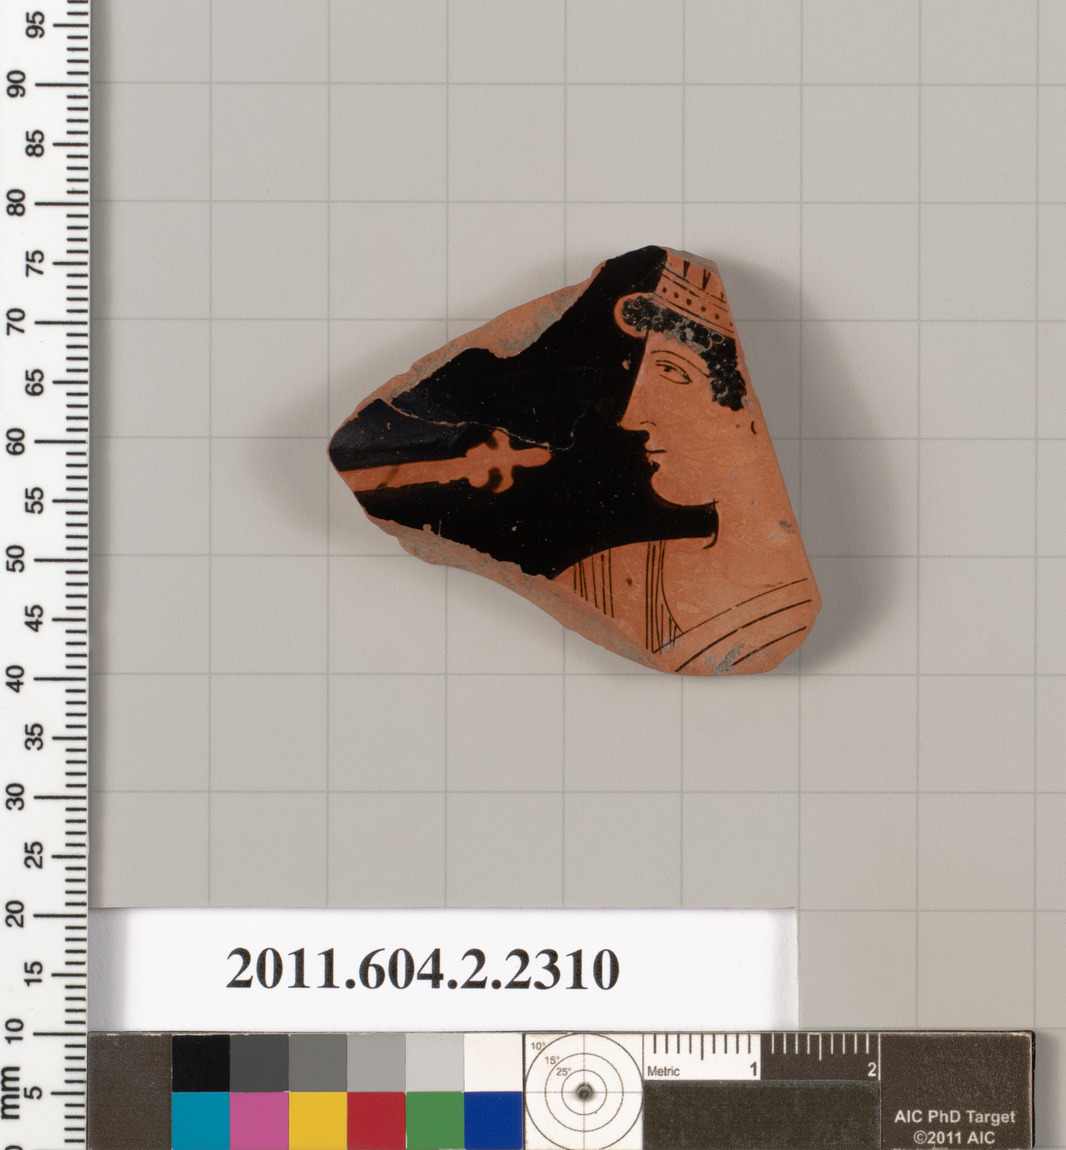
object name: pot fragment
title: Terracotta fragment of a pot; unglazed on the inside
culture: greek, attic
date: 480-470 BCE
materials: terracotta